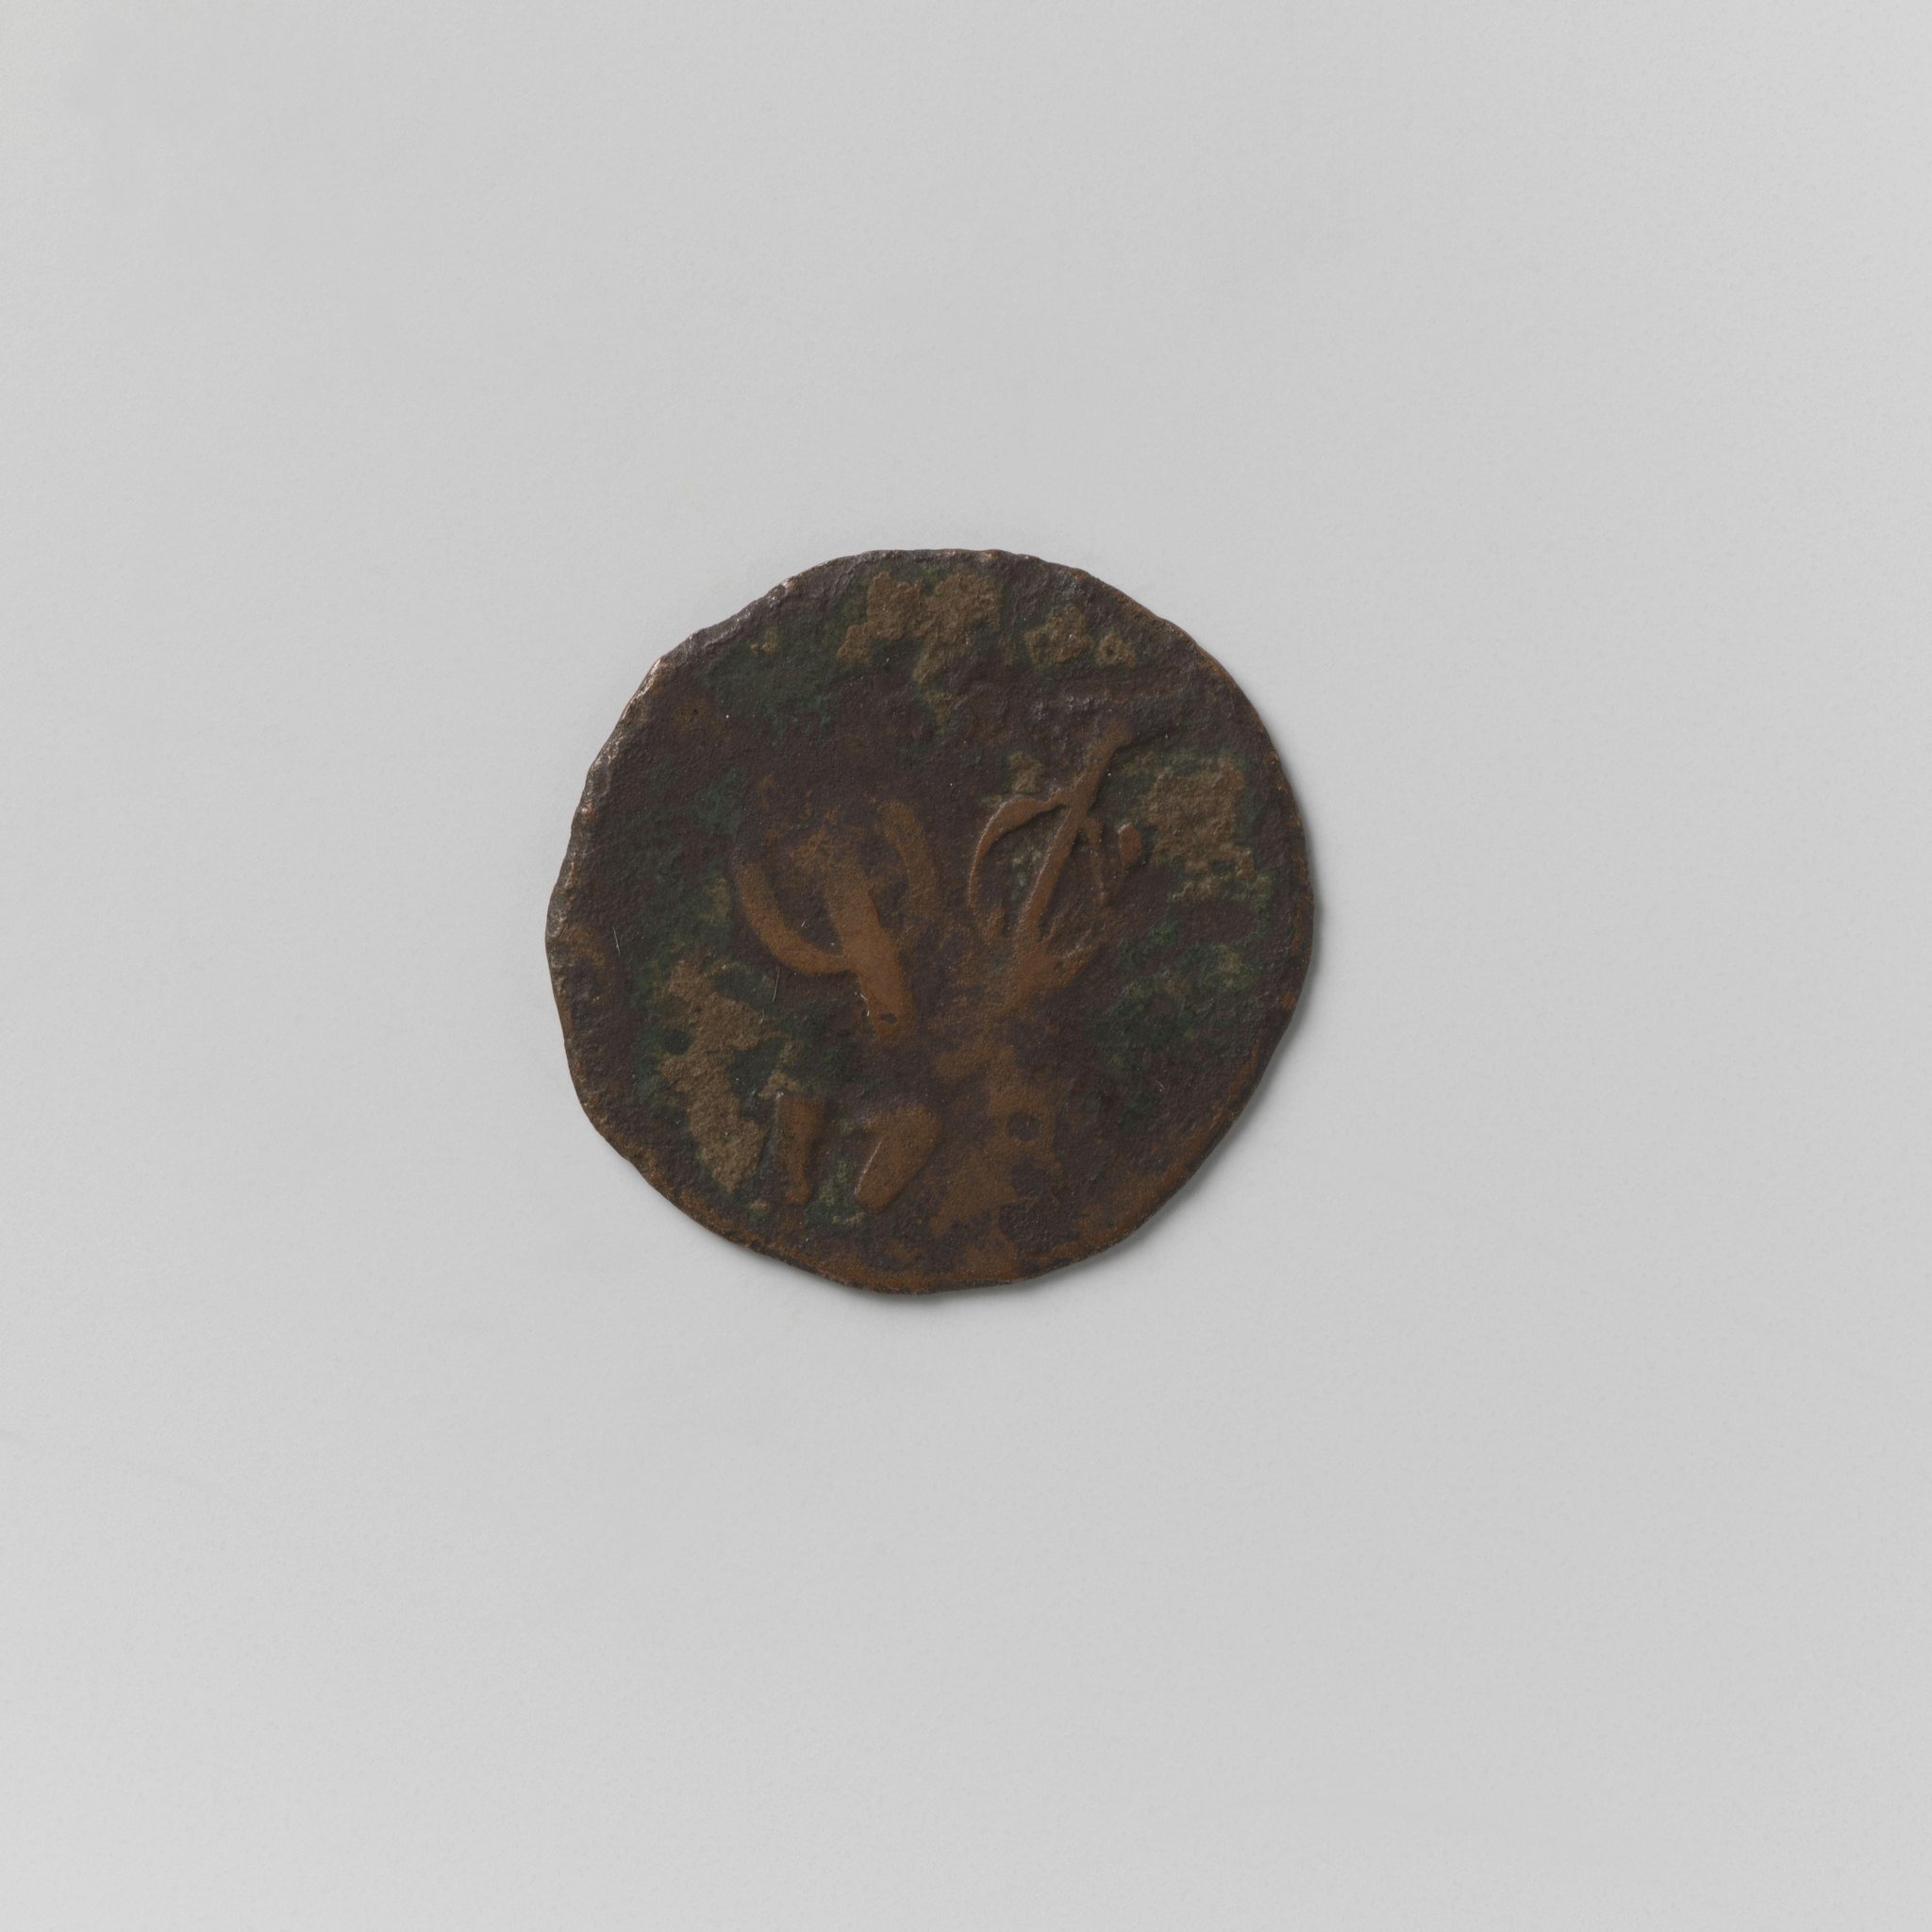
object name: coin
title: Valse ½ duit van de VOC uit Holland, 1783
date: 1783-1799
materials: copper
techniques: striking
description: Valse koperen munt. Voorzijde: tussen wapenspreuk gekroond wapenschild van Holland. Keerzijde: monogram van de VOC, waarboven muntteken en waaronder jaartal. Vervalsing. Jaartal bestaat niet.